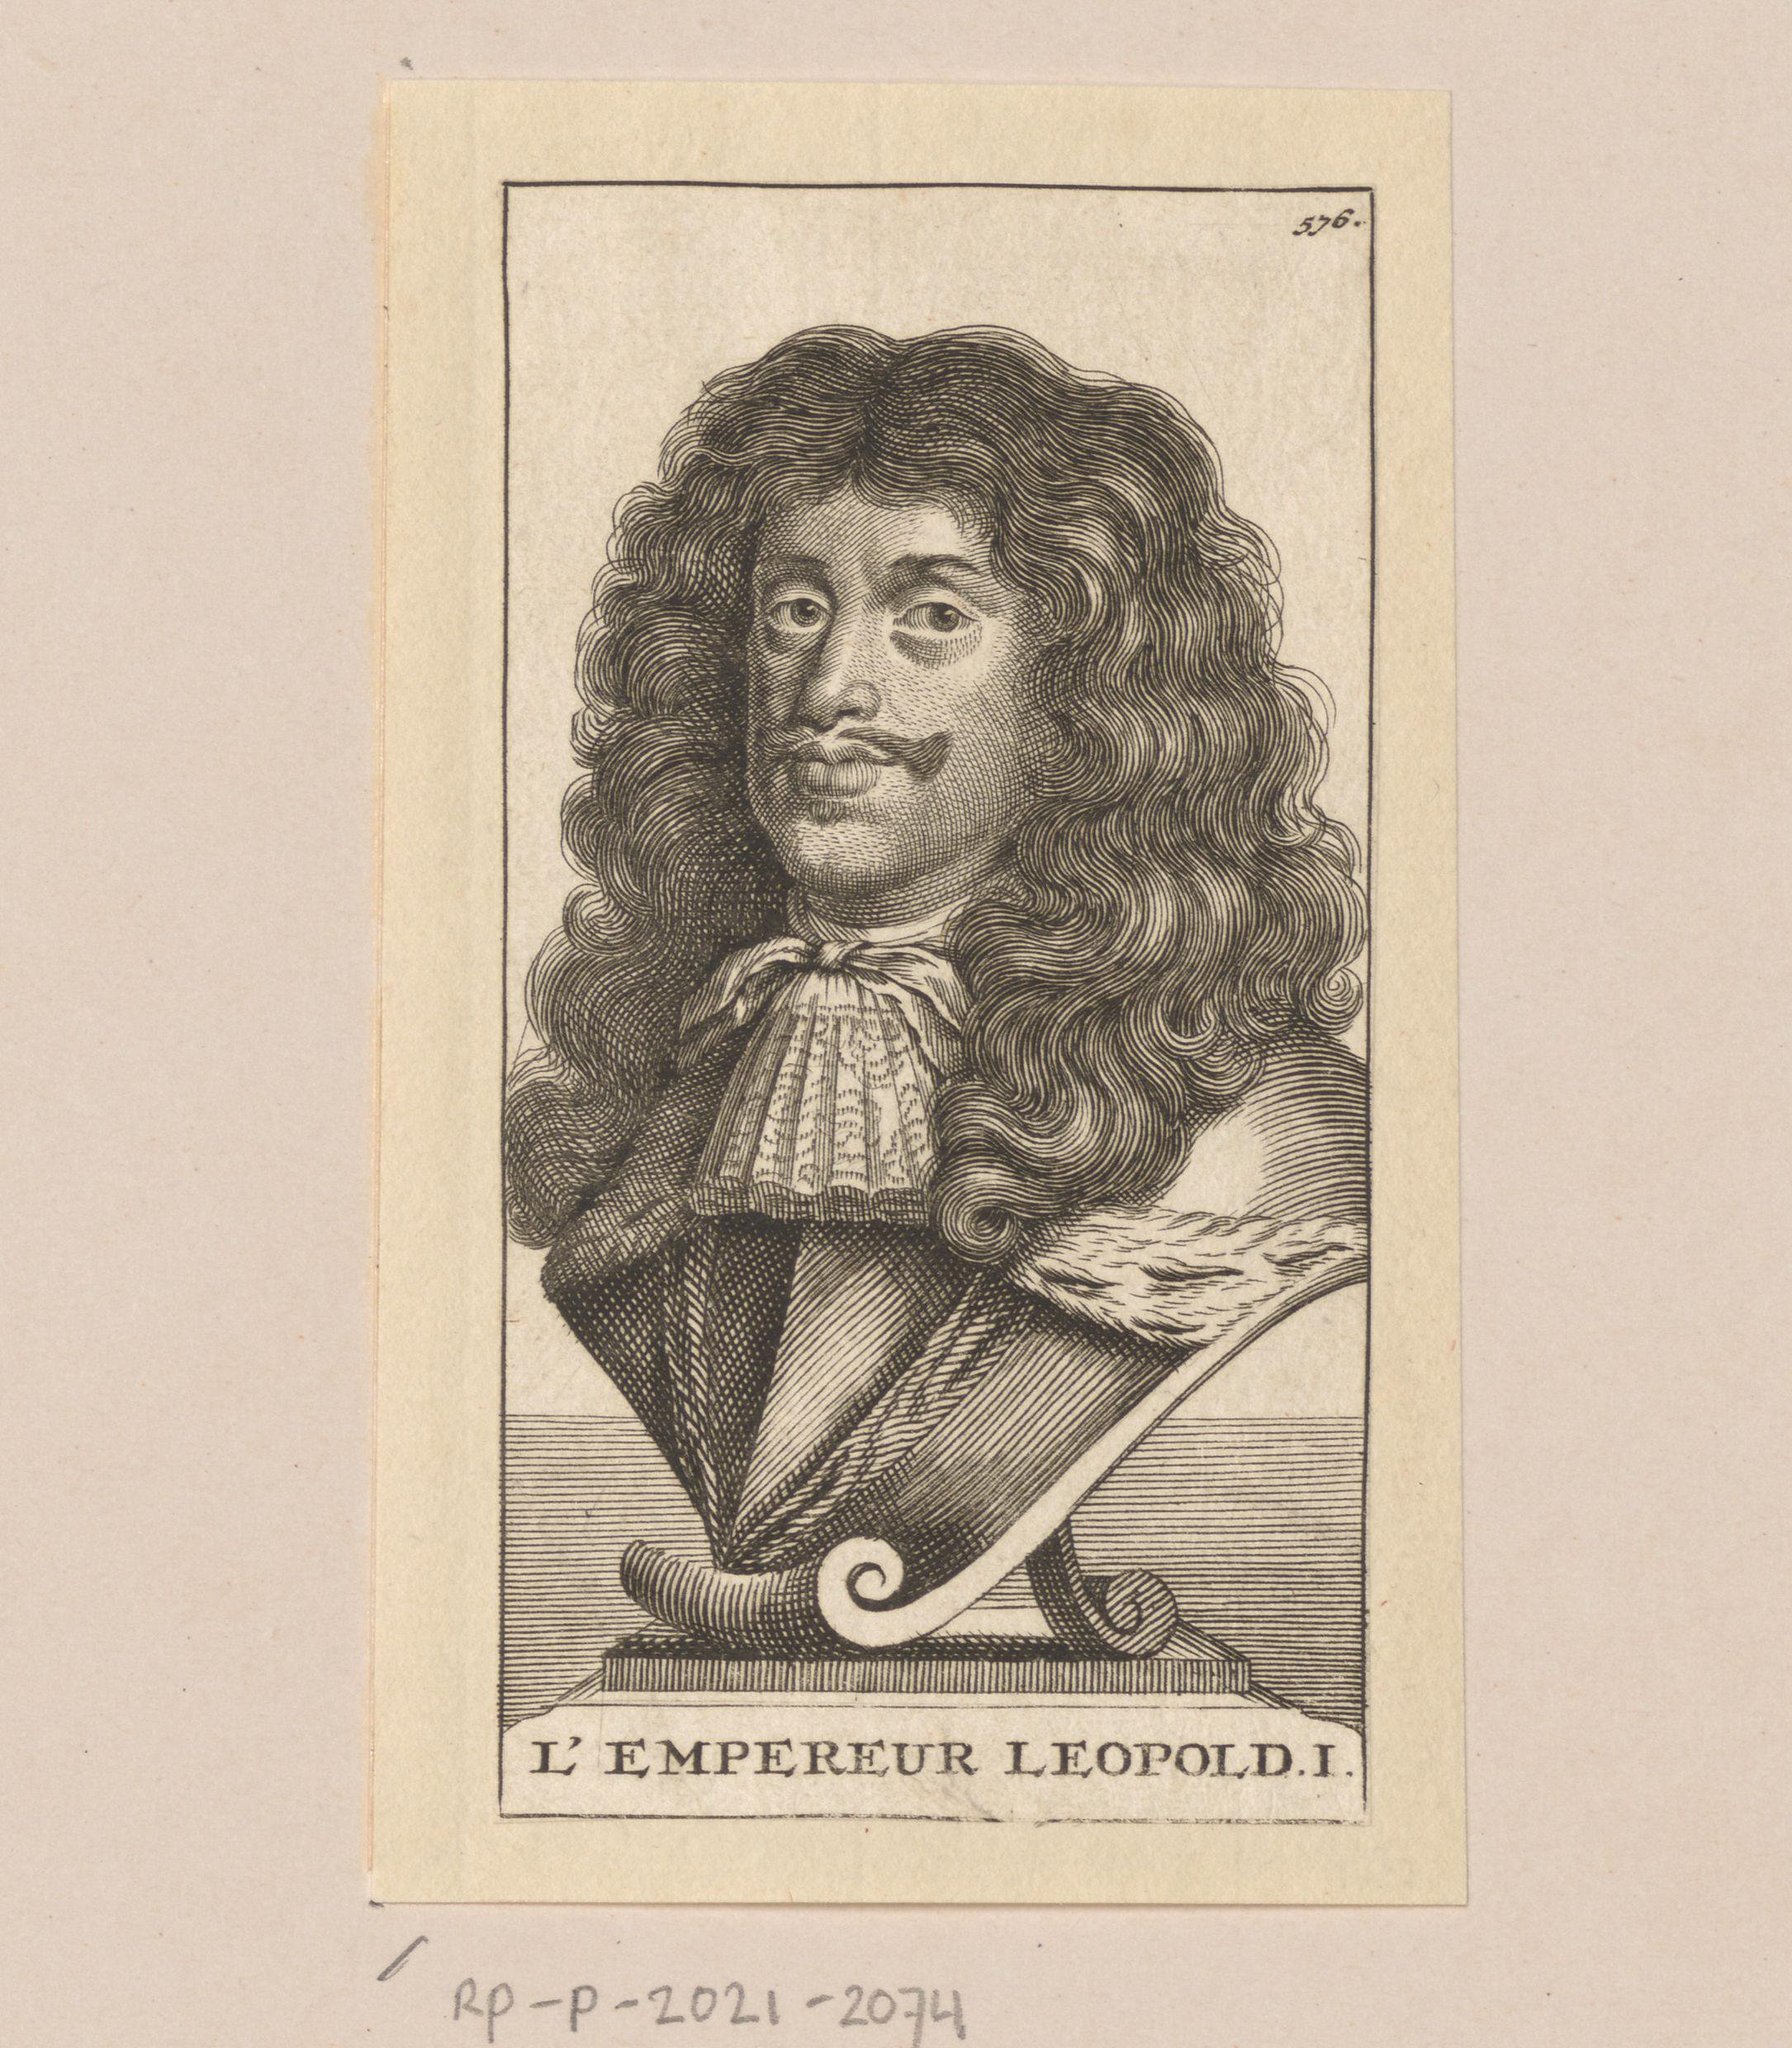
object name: print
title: Portret van keizer Leopold I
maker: Anonymous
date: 1690-1750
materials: paper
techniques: engraving, etching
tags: vienna, leopold i (keizer van duitsland), historical persons, emperor